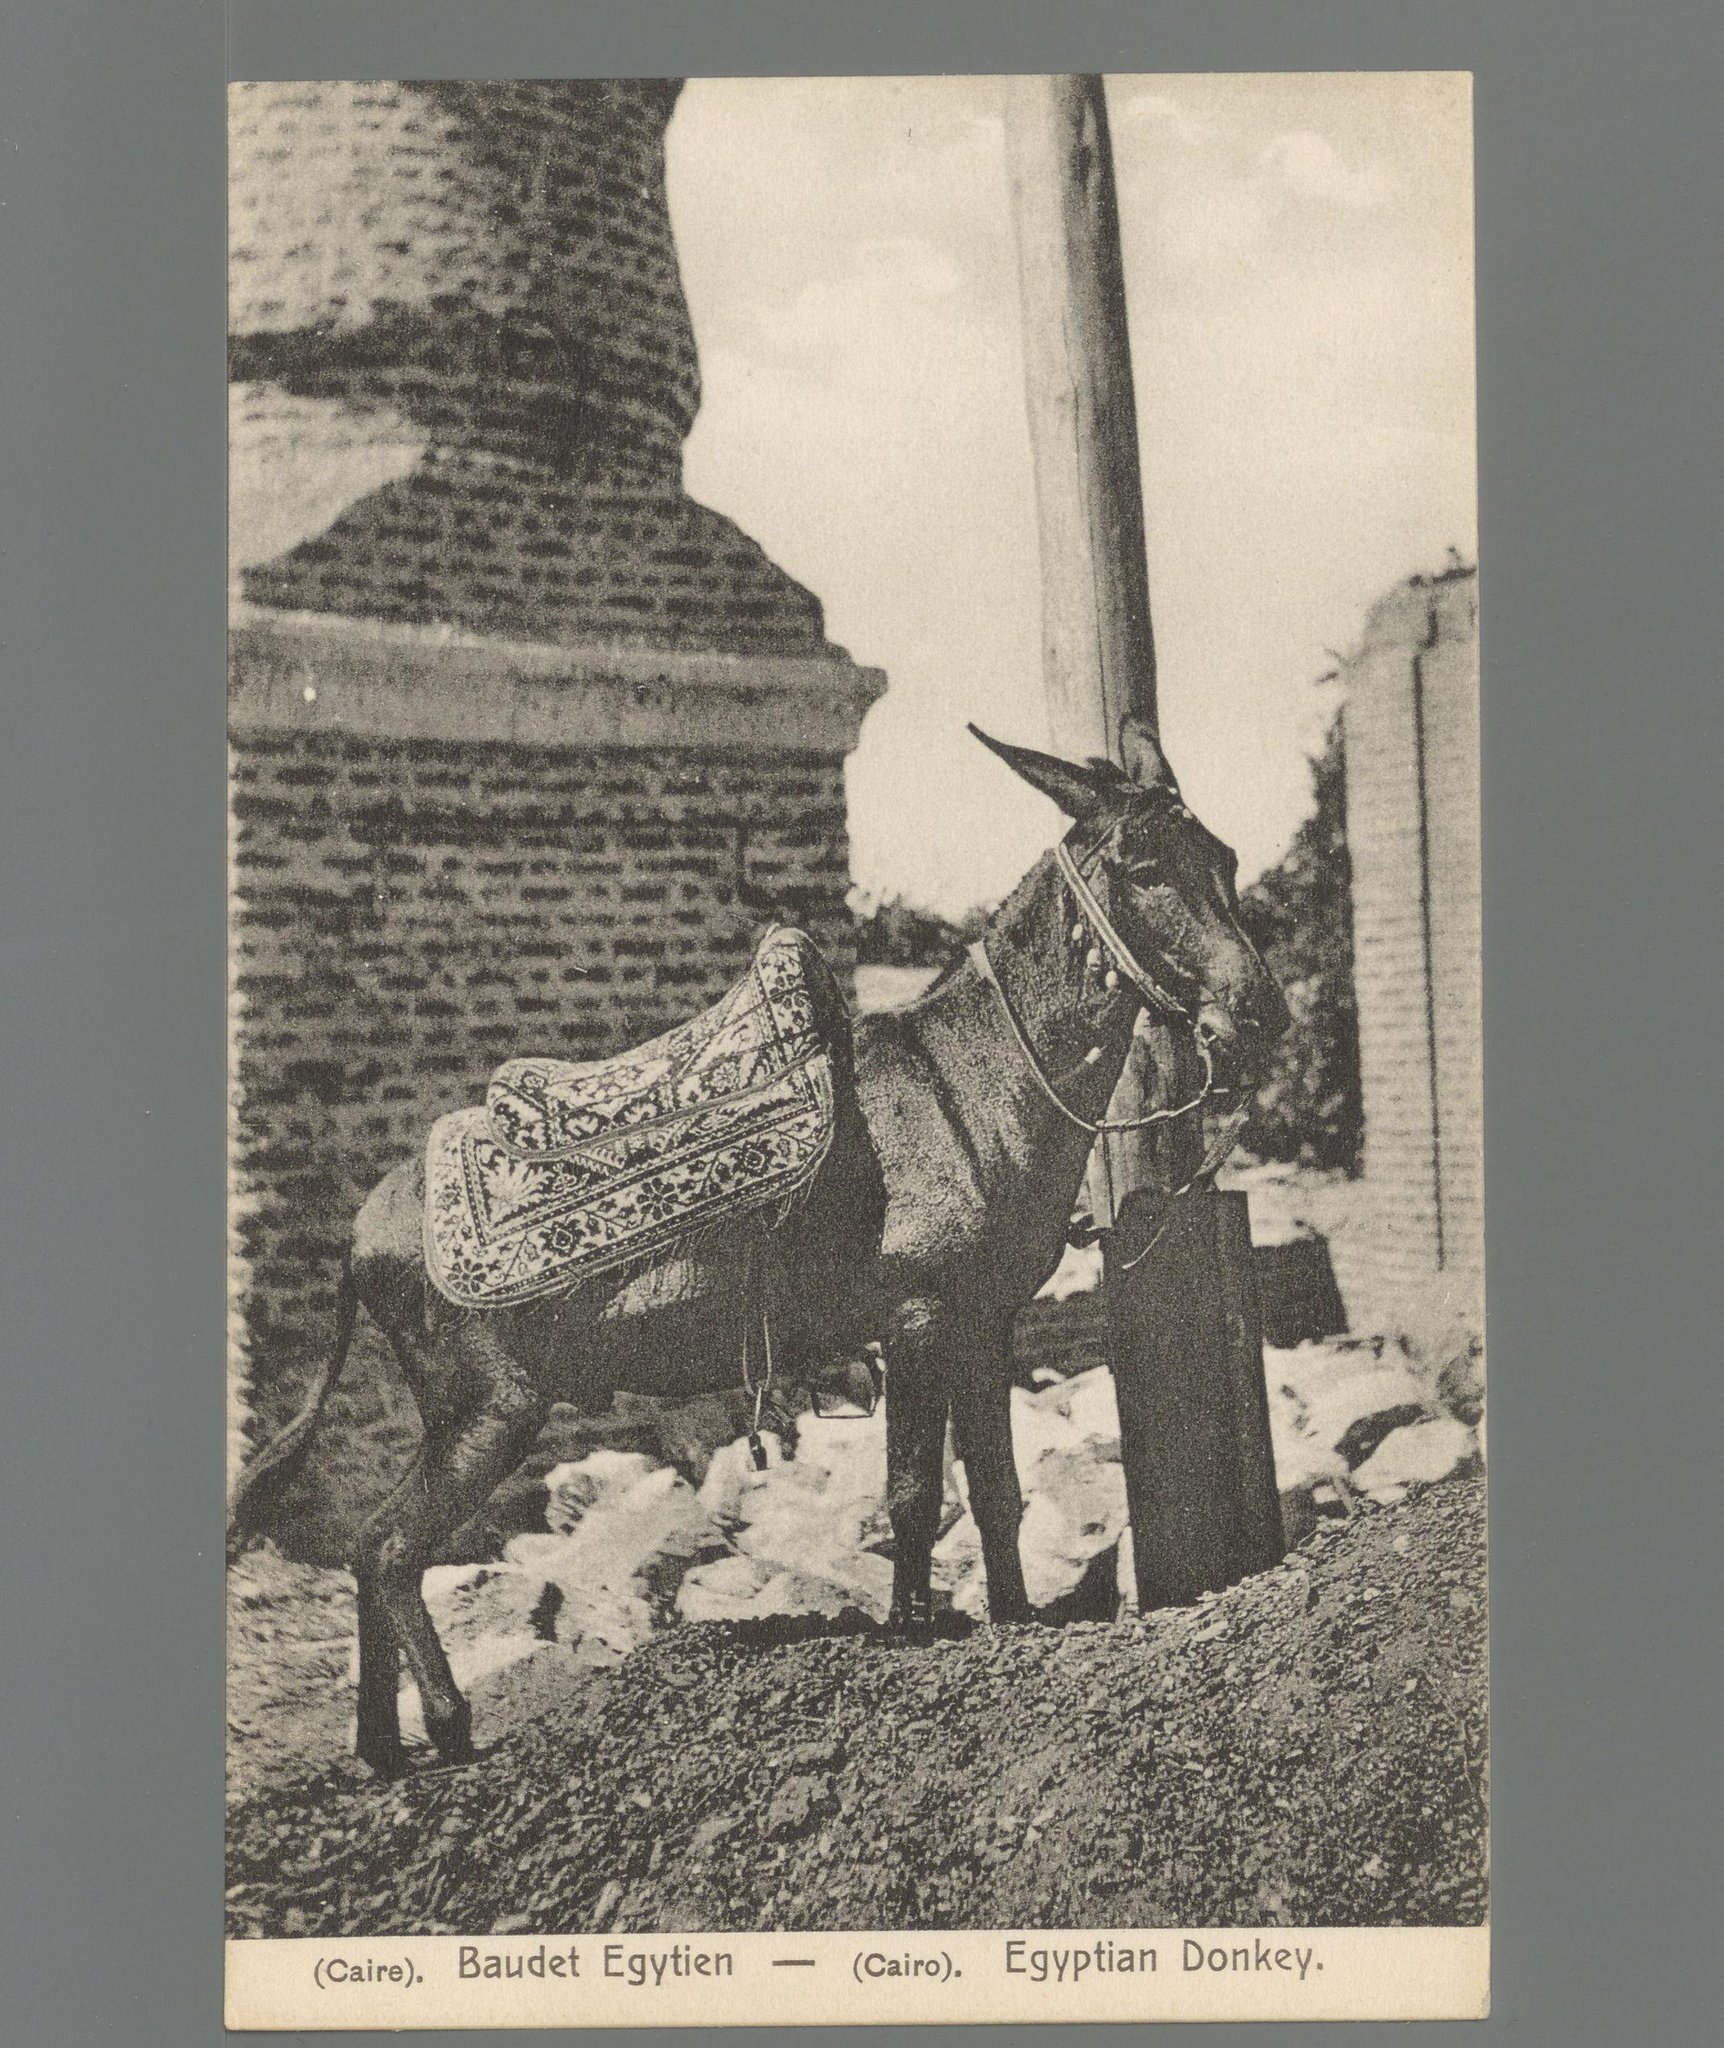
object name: photomechanical print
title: (Caire). Baudet Egytien / (Cairo). Egyptian Donkey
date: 1907-1930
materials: cardboard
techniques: photograph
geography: cairo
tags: ass, donkey